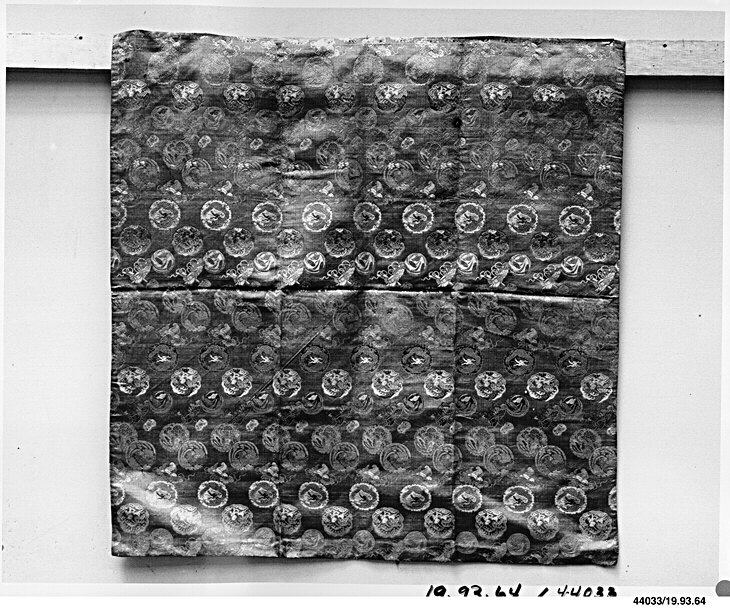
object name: altar cloth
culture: japanese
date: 1688-1704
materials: metal thread, silk